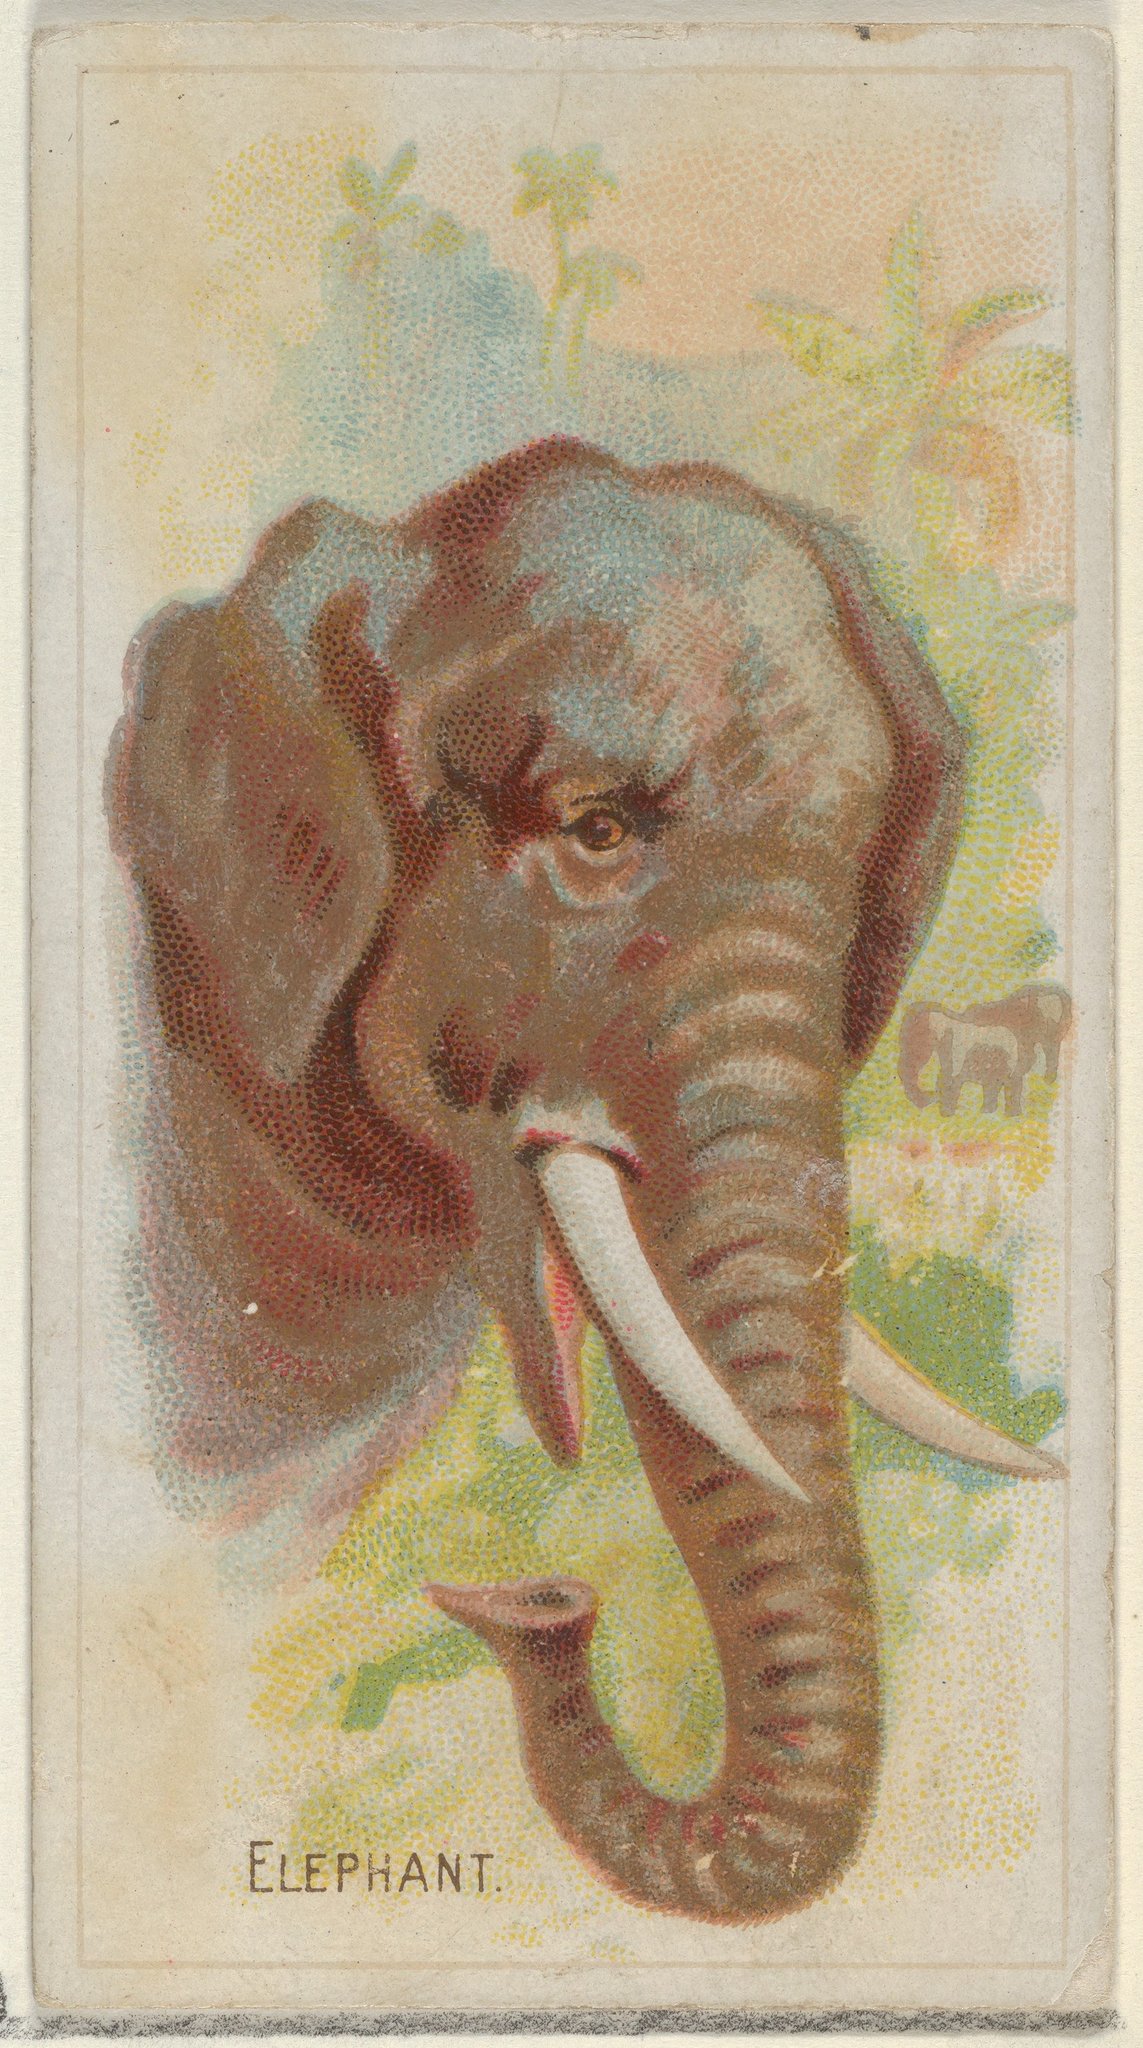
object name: print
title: Elephant, from the Wild Animals of the World series (N25) for Allen & Ginter Cigarettes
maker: allen & ginter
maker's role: publisher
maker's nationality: american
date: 1888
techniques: color lithograph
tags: elephants